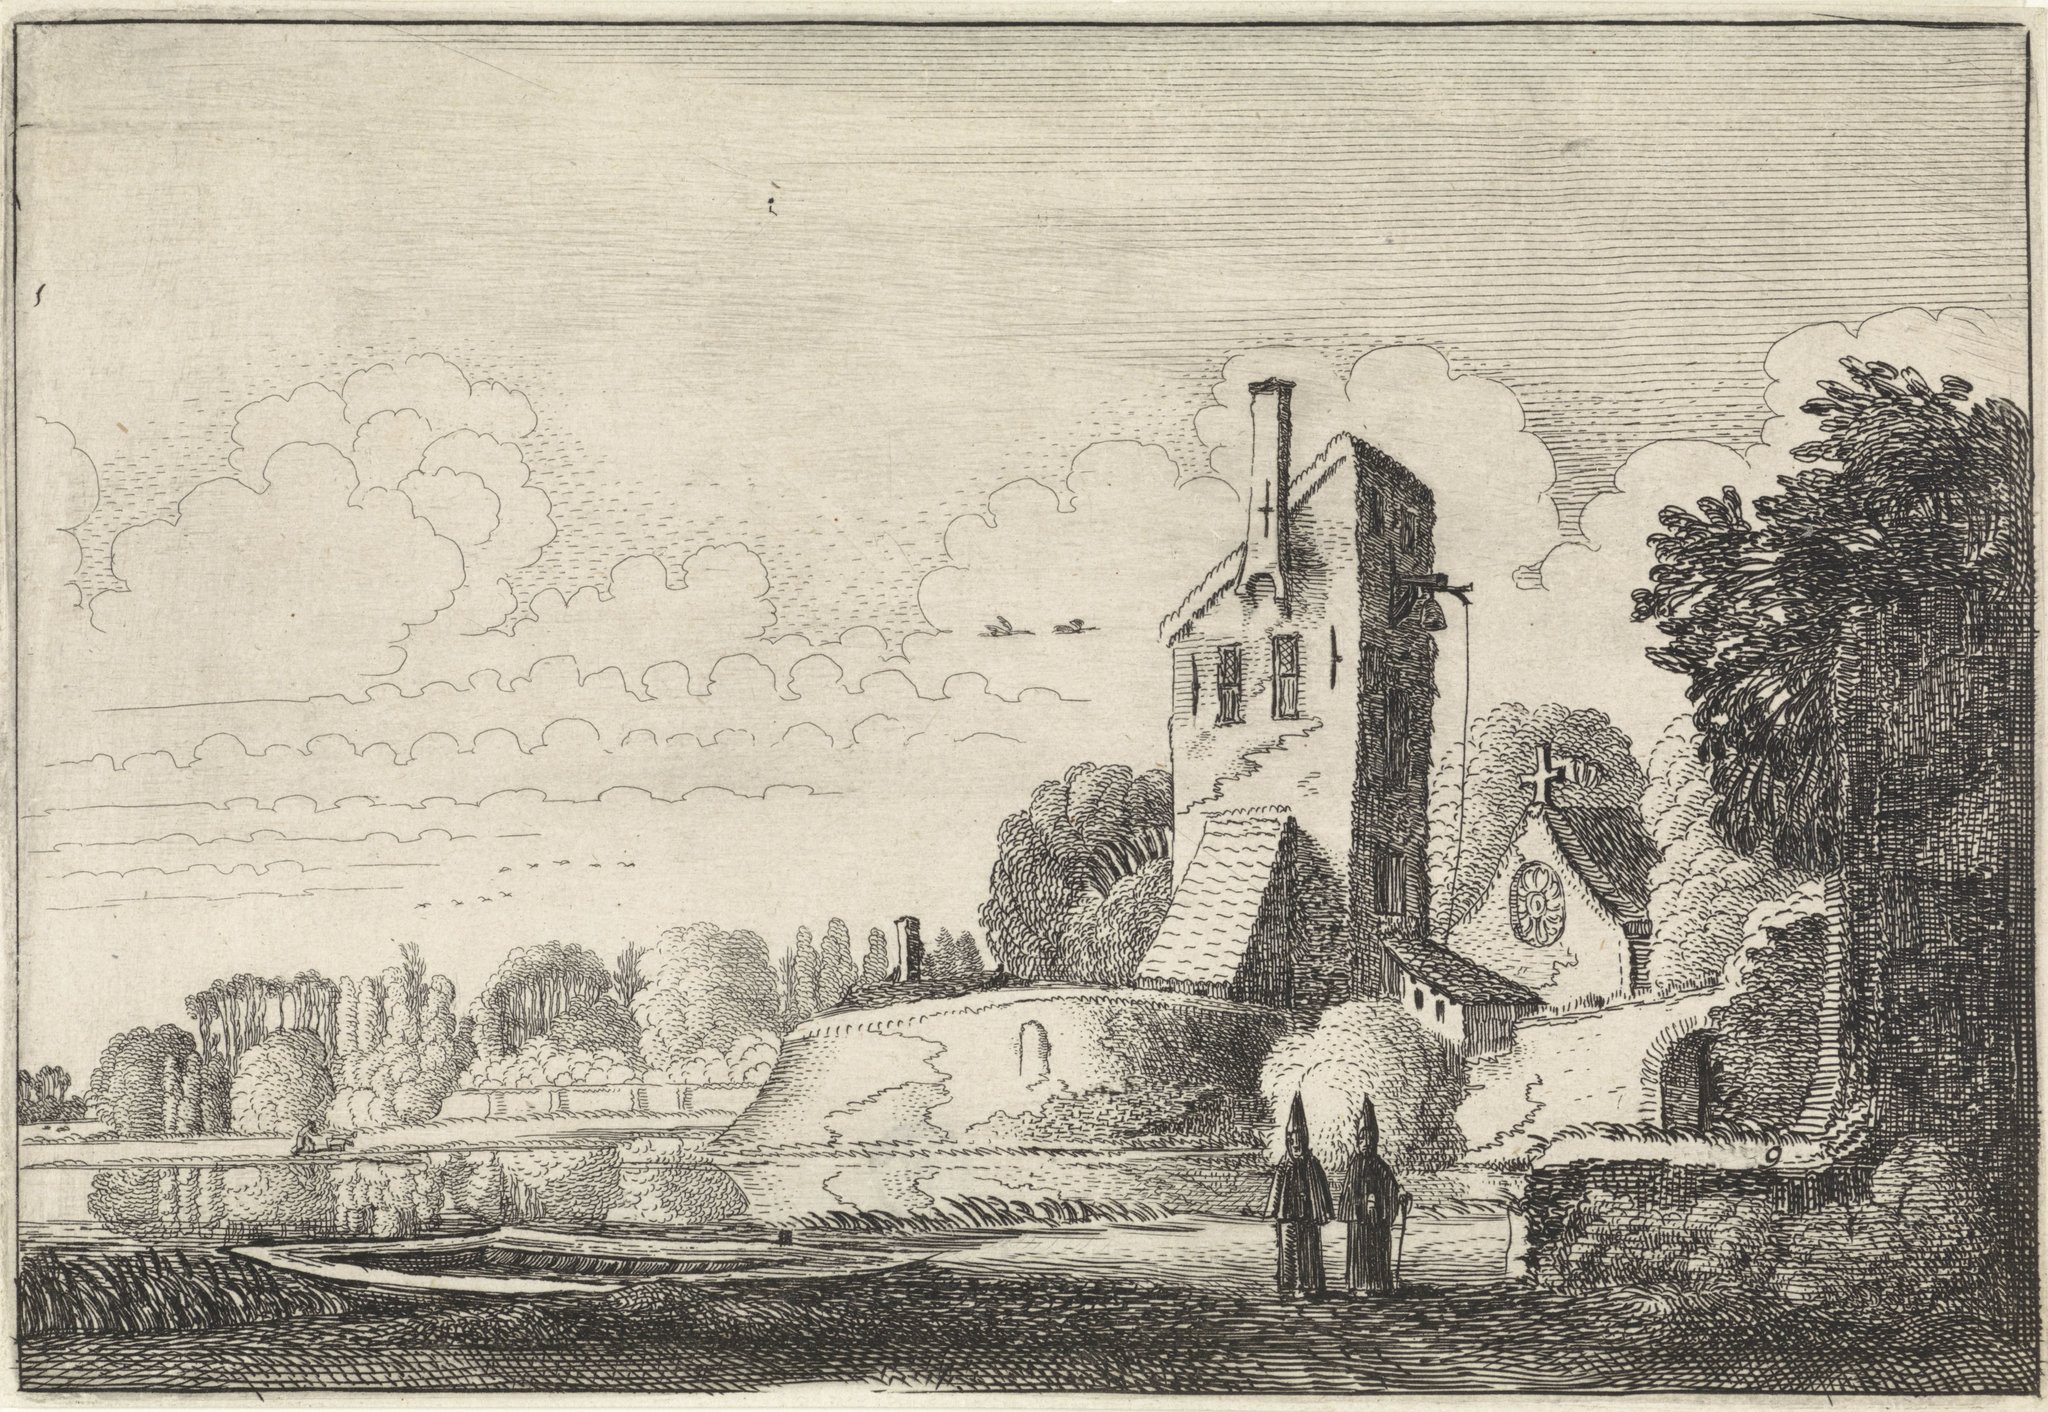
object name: print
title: Landschap met fort met toren en kapel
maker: jan van de velde (ii)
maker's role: draughtsman, painter, print maker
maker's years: 1593-1641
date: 1616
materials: paper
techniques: etching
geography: northern netherlands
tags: fortress, church (exterior), monk(s), friar(s), landscape with tower or castle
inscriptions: collector's mark: Lugt 964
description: Landschap met een aan het water gelegen fort met toren. Daarachter een kapel. Op de voorgrond wandelen twee kloosterlingen over een pad. Negende prent van deel twee van een serie van in totaal zestig prenten met landschappen, verdeeld over vijf delen van elk twaalf prenten.